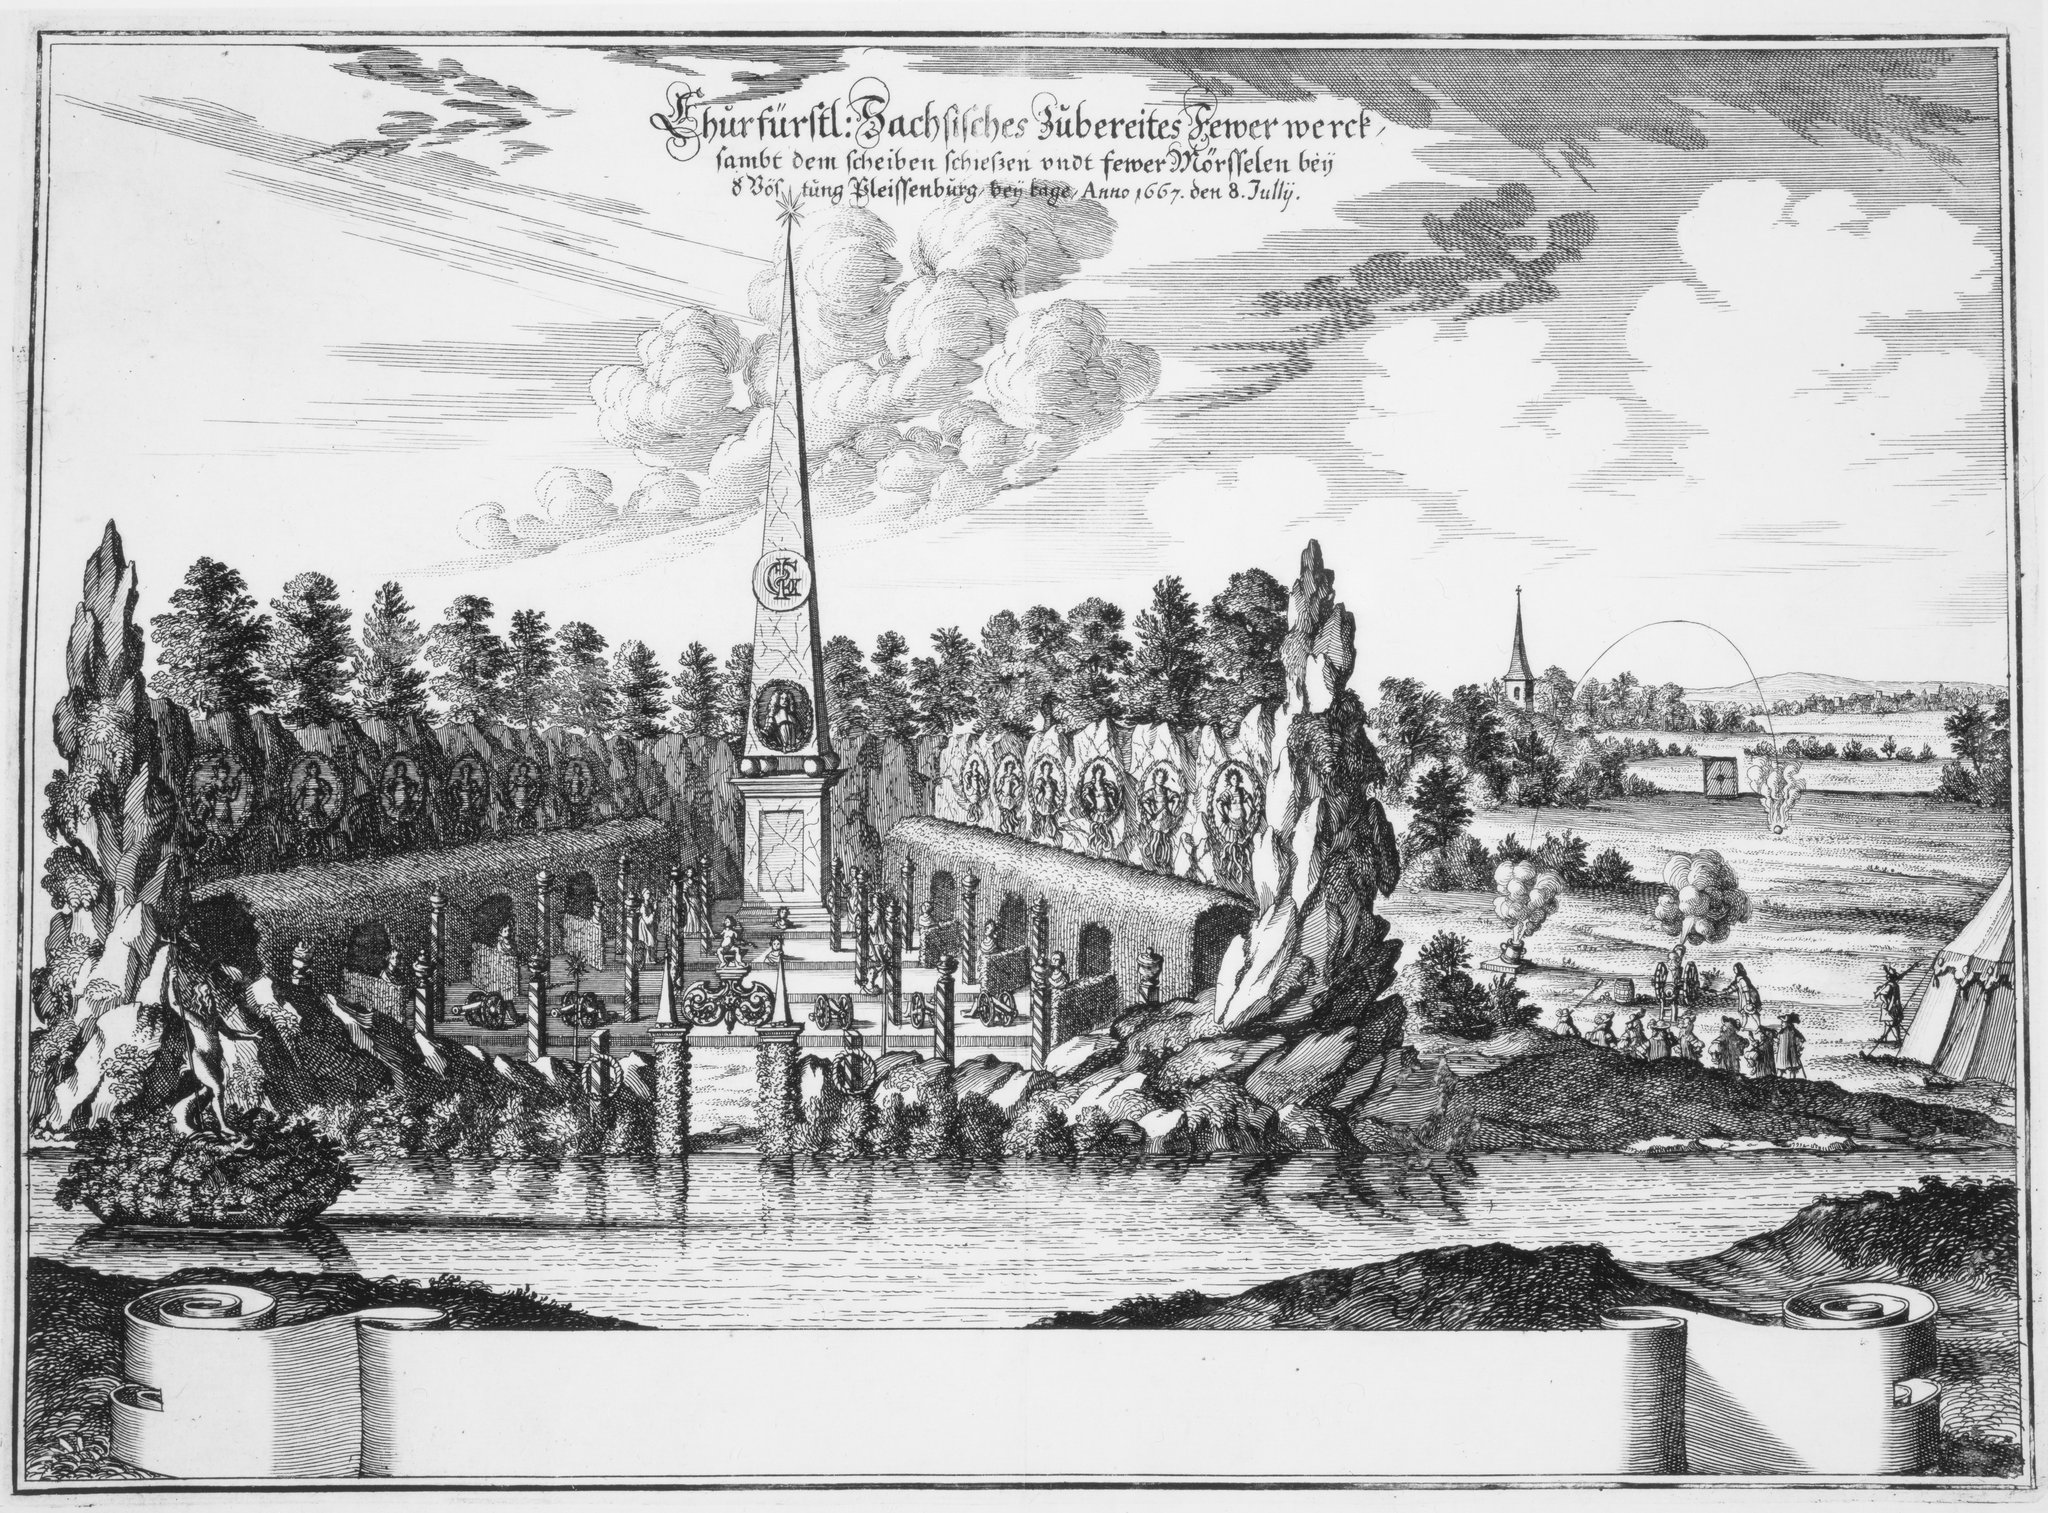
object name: print, fete, ornament architecture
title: Celebration for the Elector Johann Georg II, Leipzig, July 8, 1667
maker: anonymous, german, 17th century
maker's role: artist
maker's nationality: german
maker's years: 1600-1700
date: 1667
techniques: engraving, etching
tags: obelisks